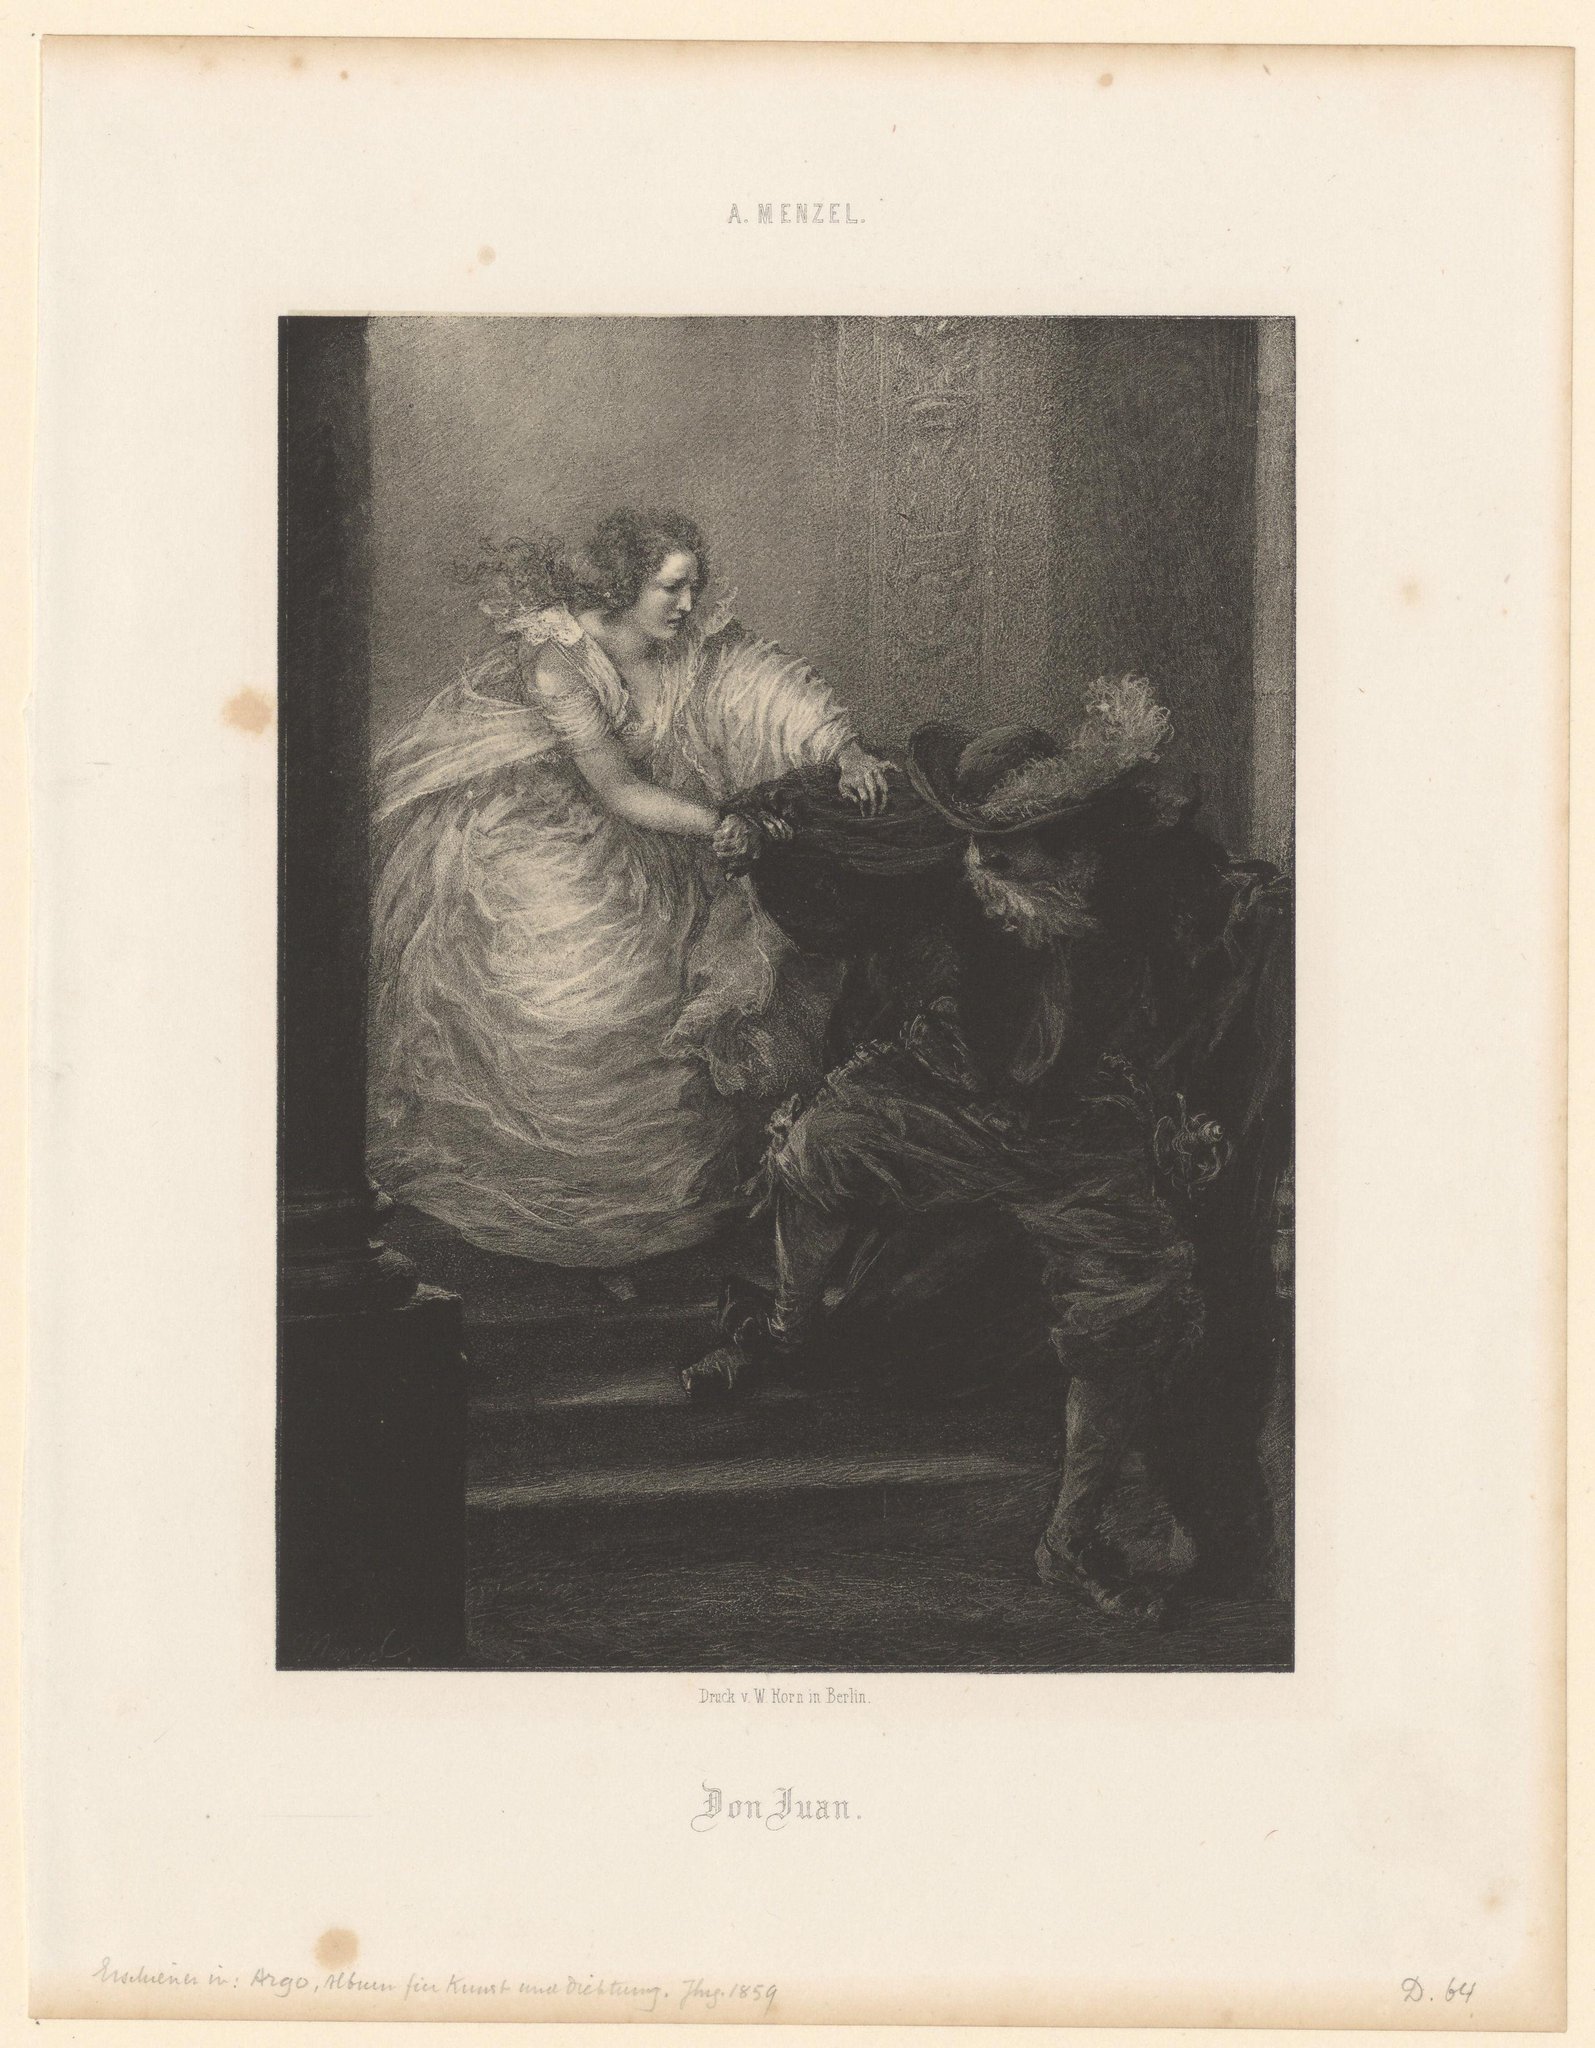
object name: print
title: Don Juan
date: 1859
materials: paper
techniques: lithograph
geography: berlin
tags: theatre, theatrical performance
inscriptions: collector's mark: Lugt 2228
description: Prent uit: Argo, Album für Kunst und Dichtung (1859).